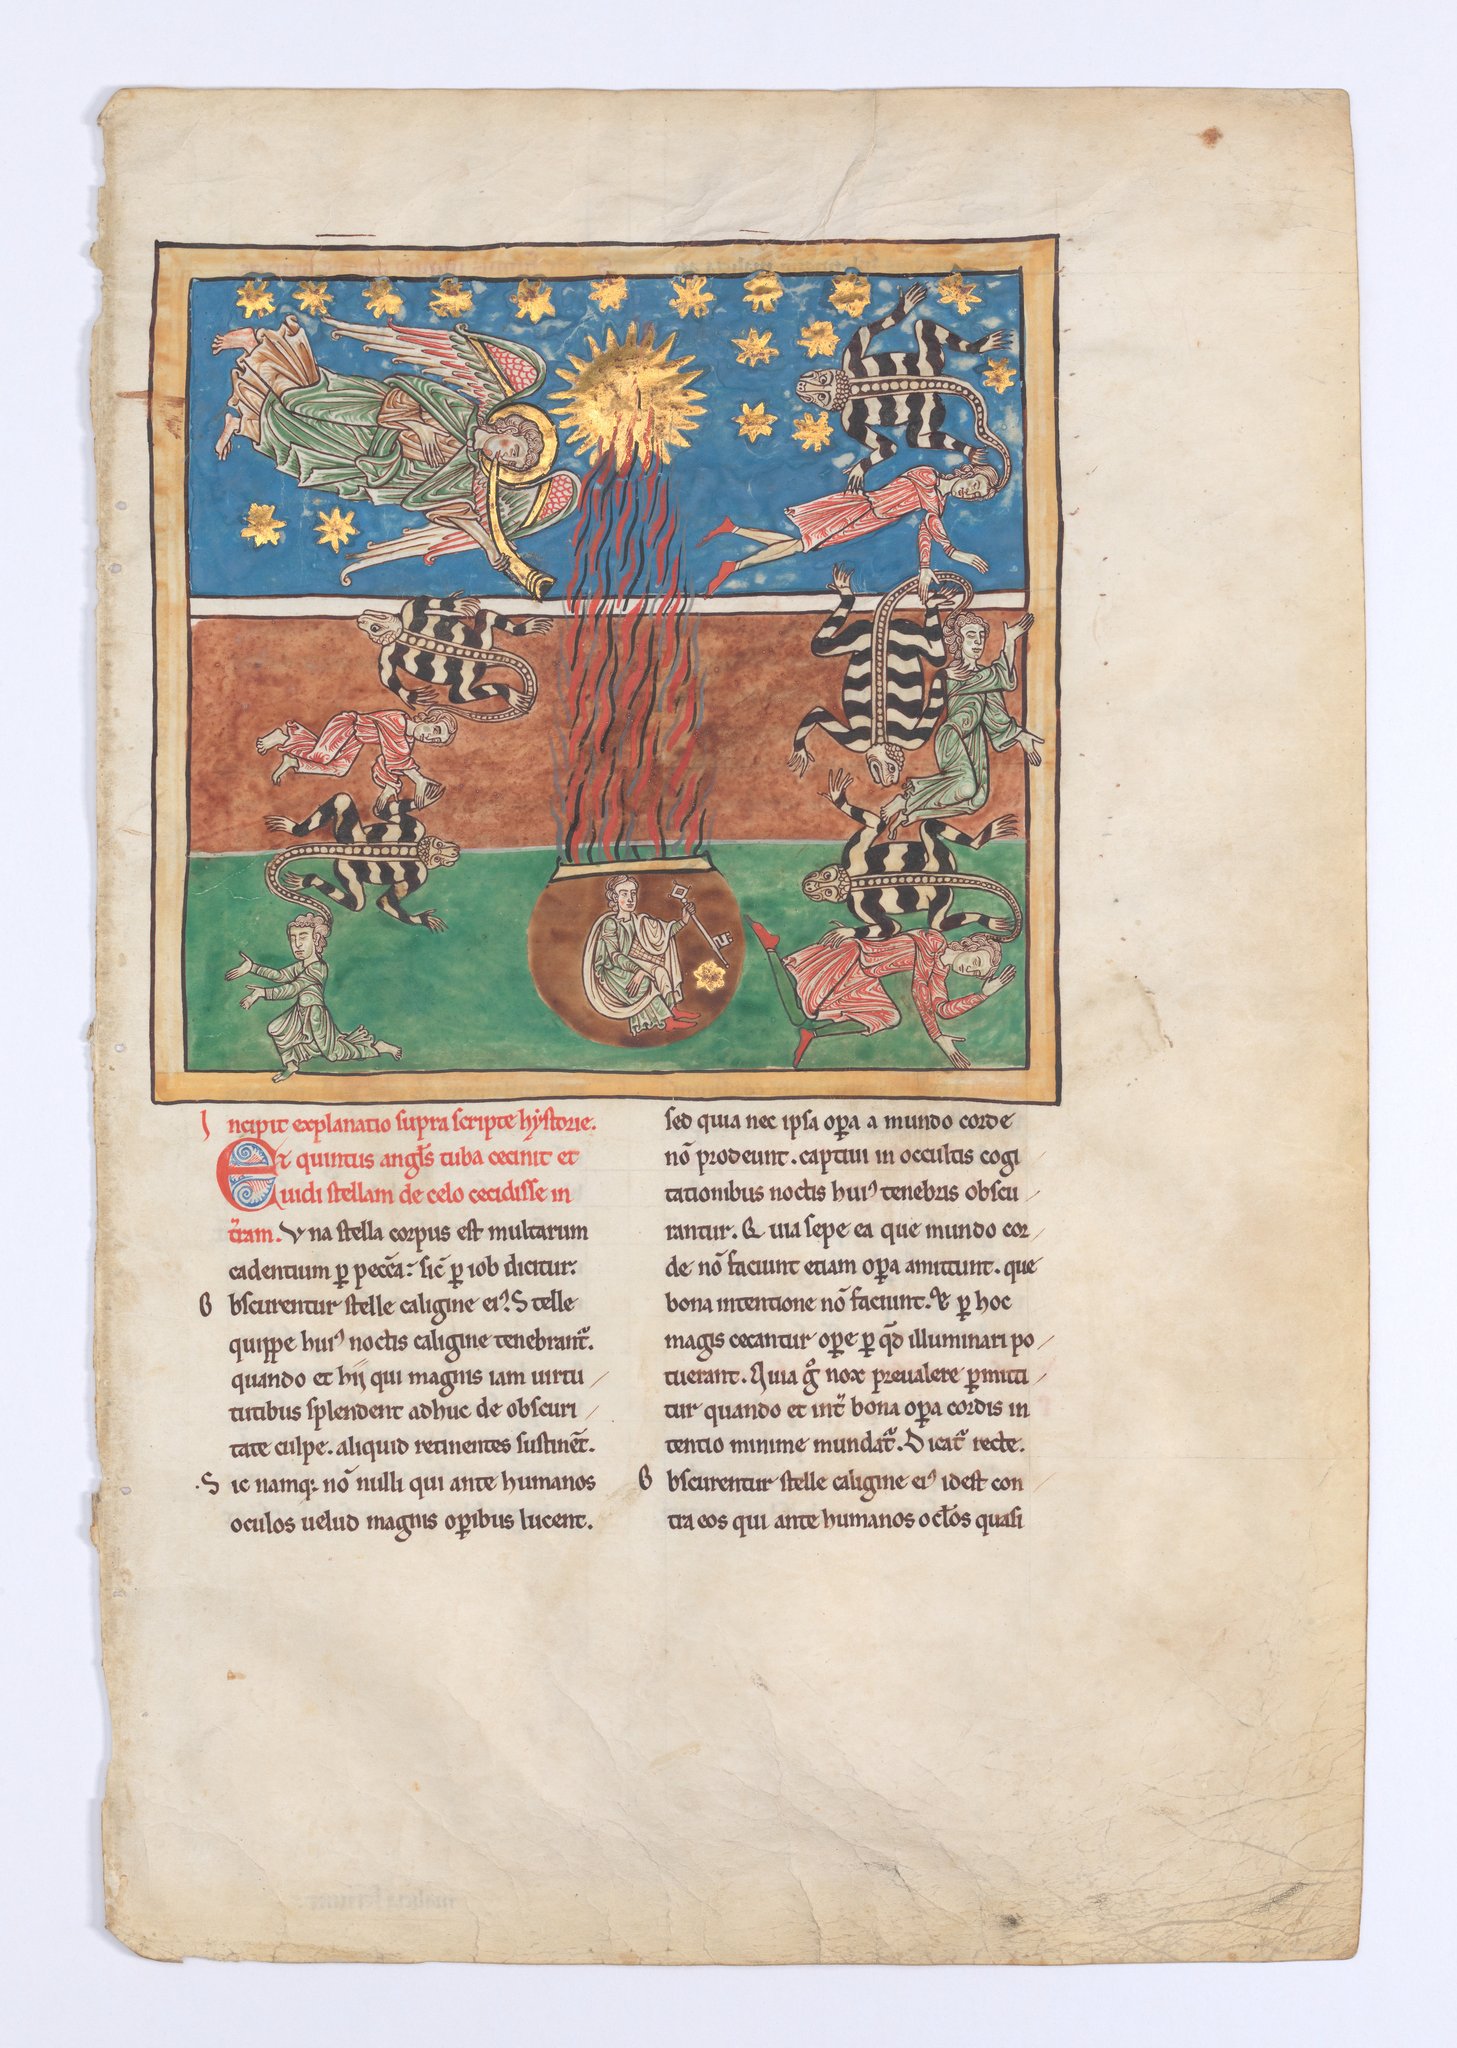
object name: beatus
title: Leaf from a Beatus Manuscript: at the Clarion of the Fifth Angel's Trumpet, a Star Falls from the Sky; the Bottomless Pit is Opened with a Key; Emerging from the Smoke, Locusts Come Upon the Earth and Torment the Deathless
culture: spanish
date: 1180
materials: gold, ink, parchment, paint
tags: angels